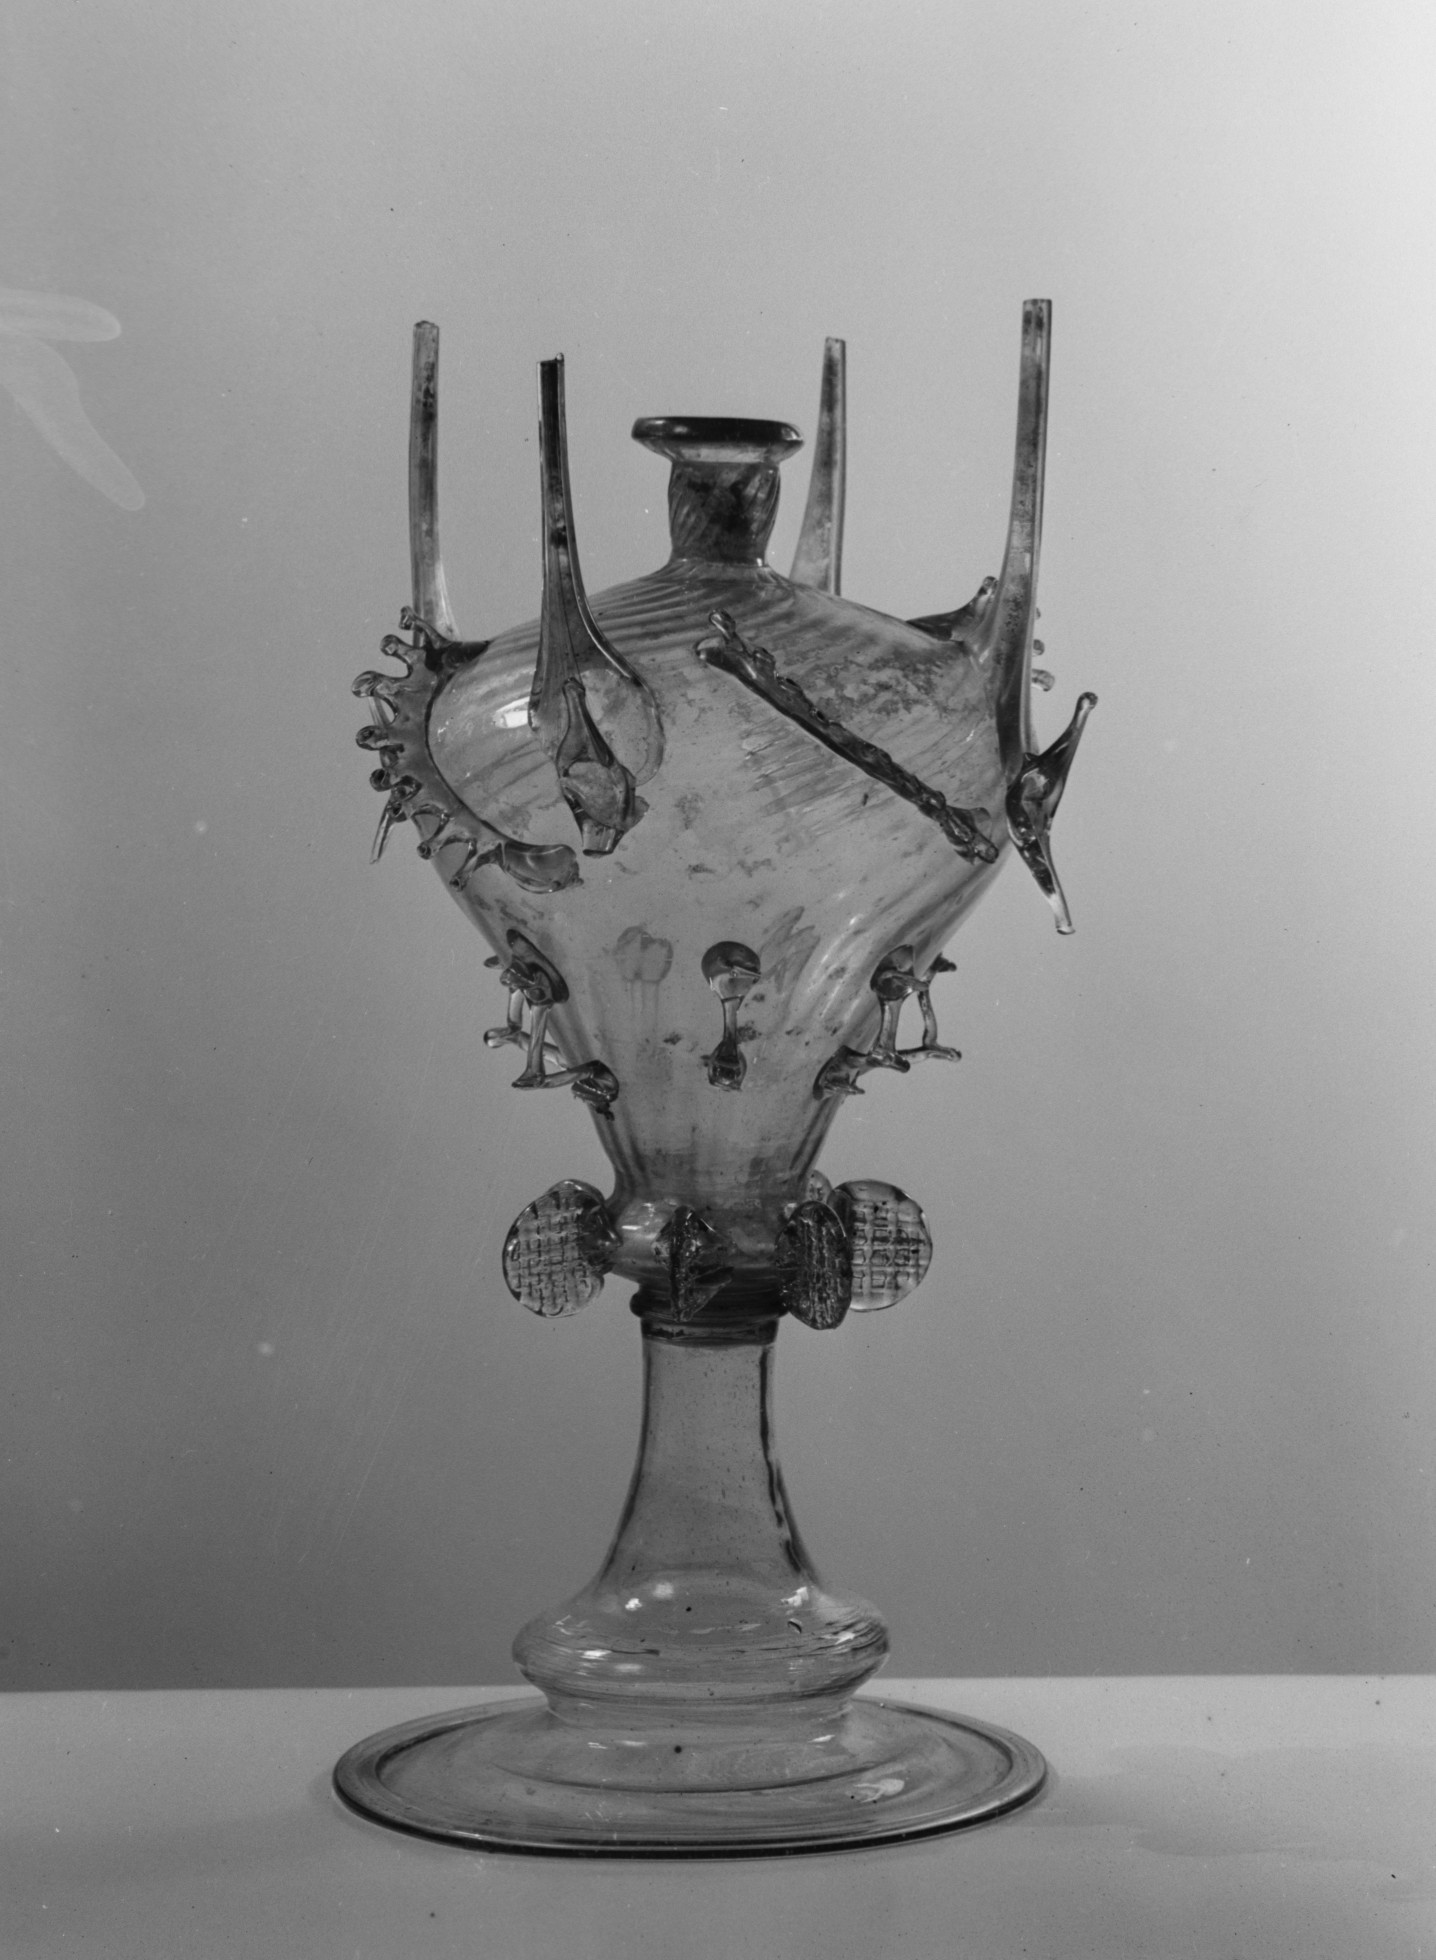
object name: rosewater sprinkler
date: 1701-1800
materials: glass